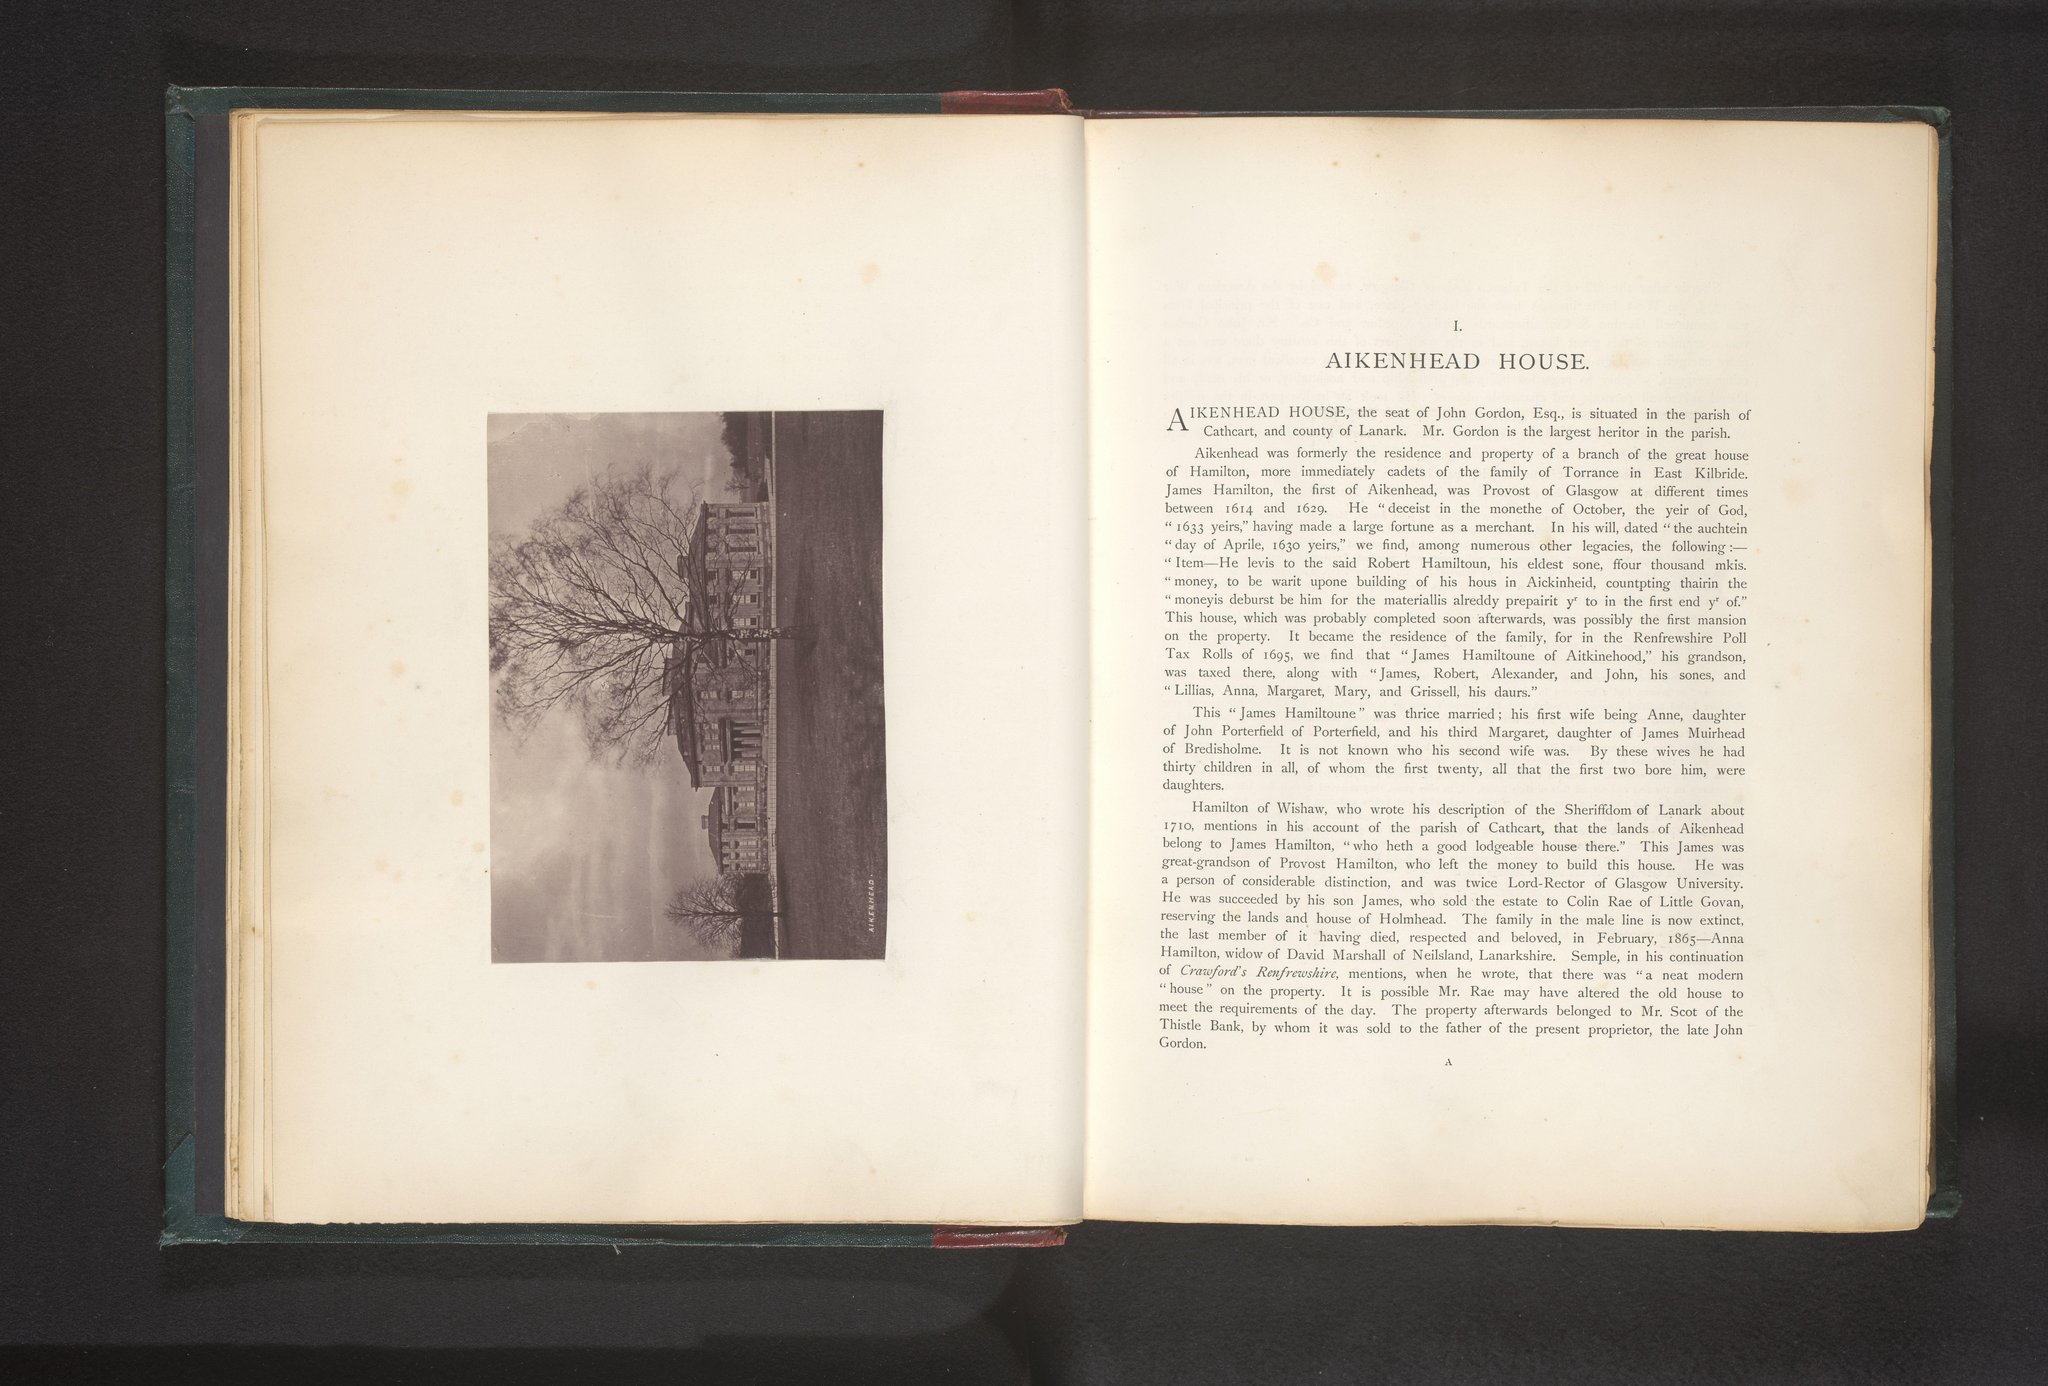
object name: photograph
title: Aikenhead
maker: thomas annan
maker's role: fotograaf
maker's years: 1829-1887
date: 1868-1878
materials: paper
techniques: carbon print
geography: glasgow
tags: rural housing, e.g. country-house, villa, cottage, façade (of house or building)